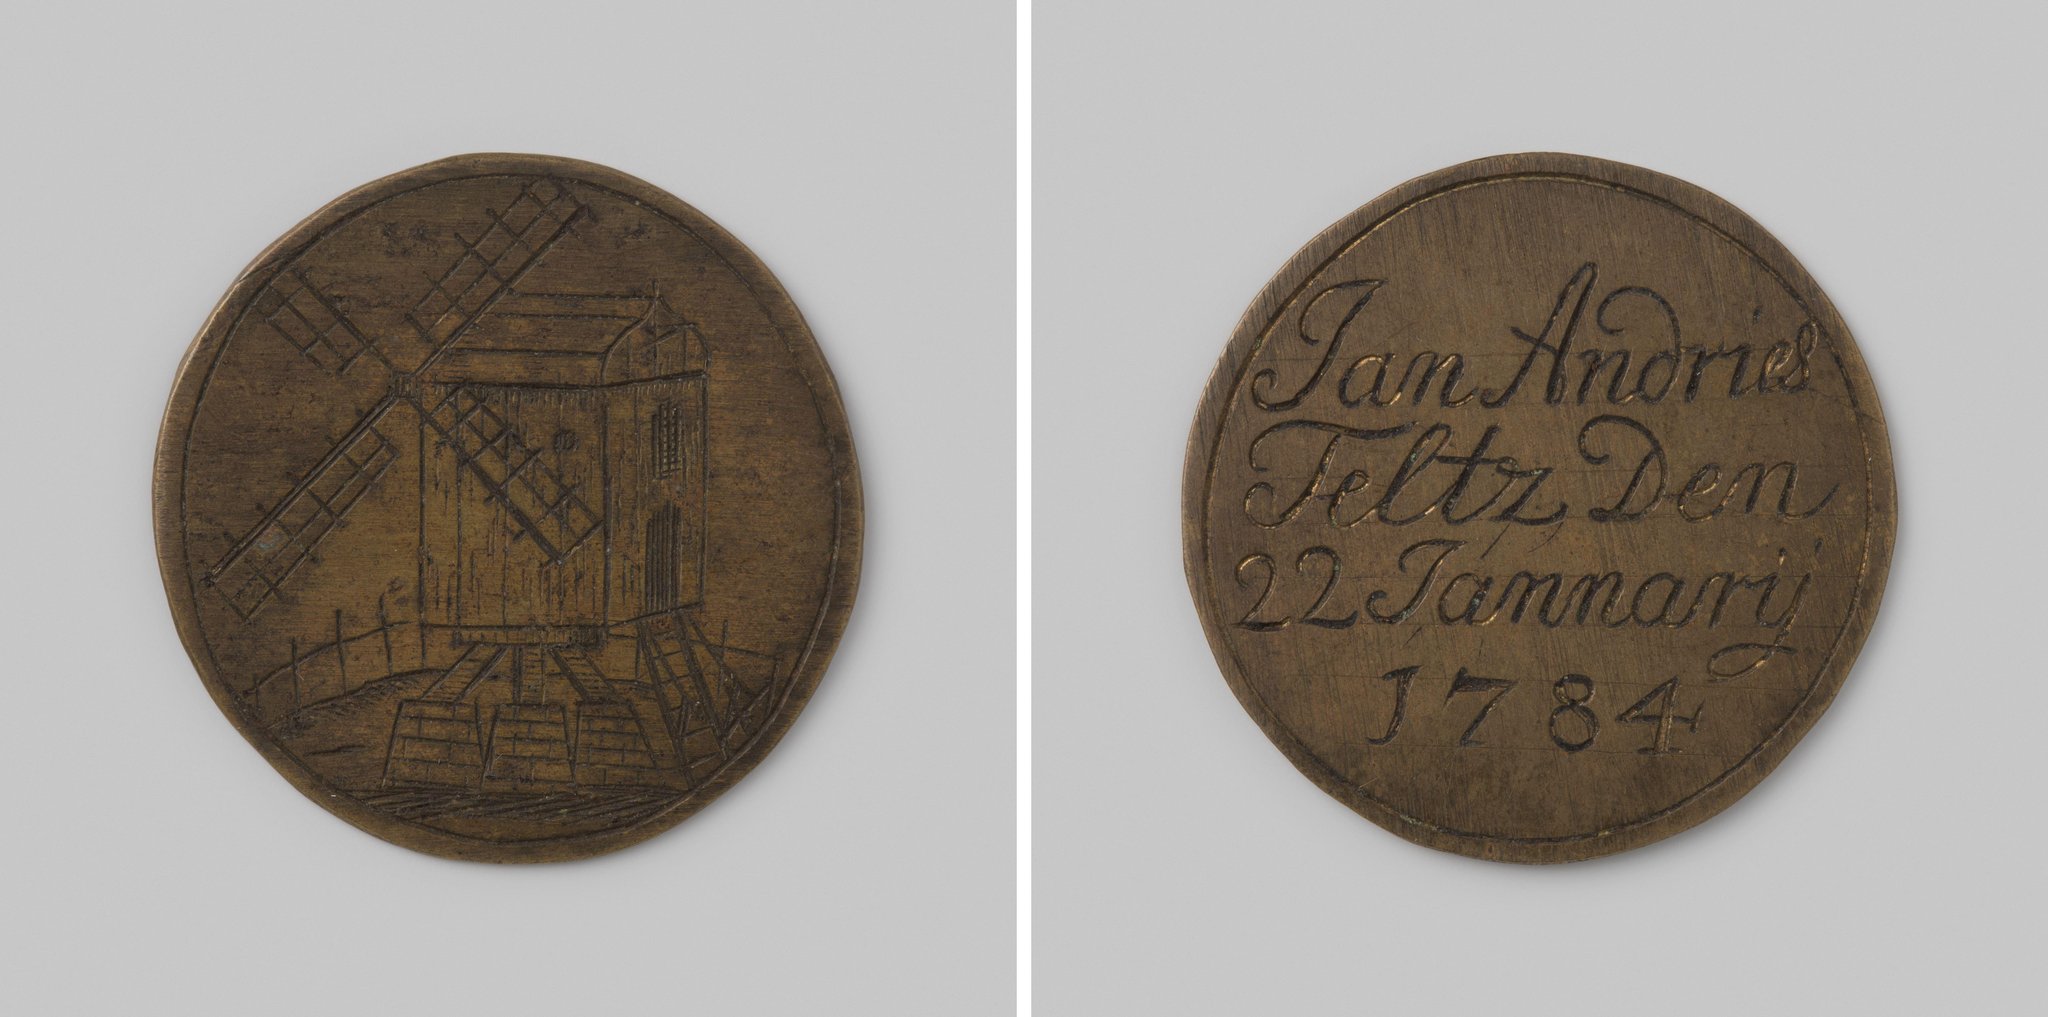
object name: medal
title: Presentiepenning van het Korenmolenaarsgilde te Amsterdam, 1683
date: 1683-1784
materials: brass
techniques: engraving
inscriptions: inscription: ‘Jan Andries / Teltz den / 22 Jannarij / 1784 (Feltz ?)’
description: Rond messing plaatje gegraveerd op de voorzijde een molen, op de keerzijde vier regels tekst, op naam van Jan Andries Teltz 1784